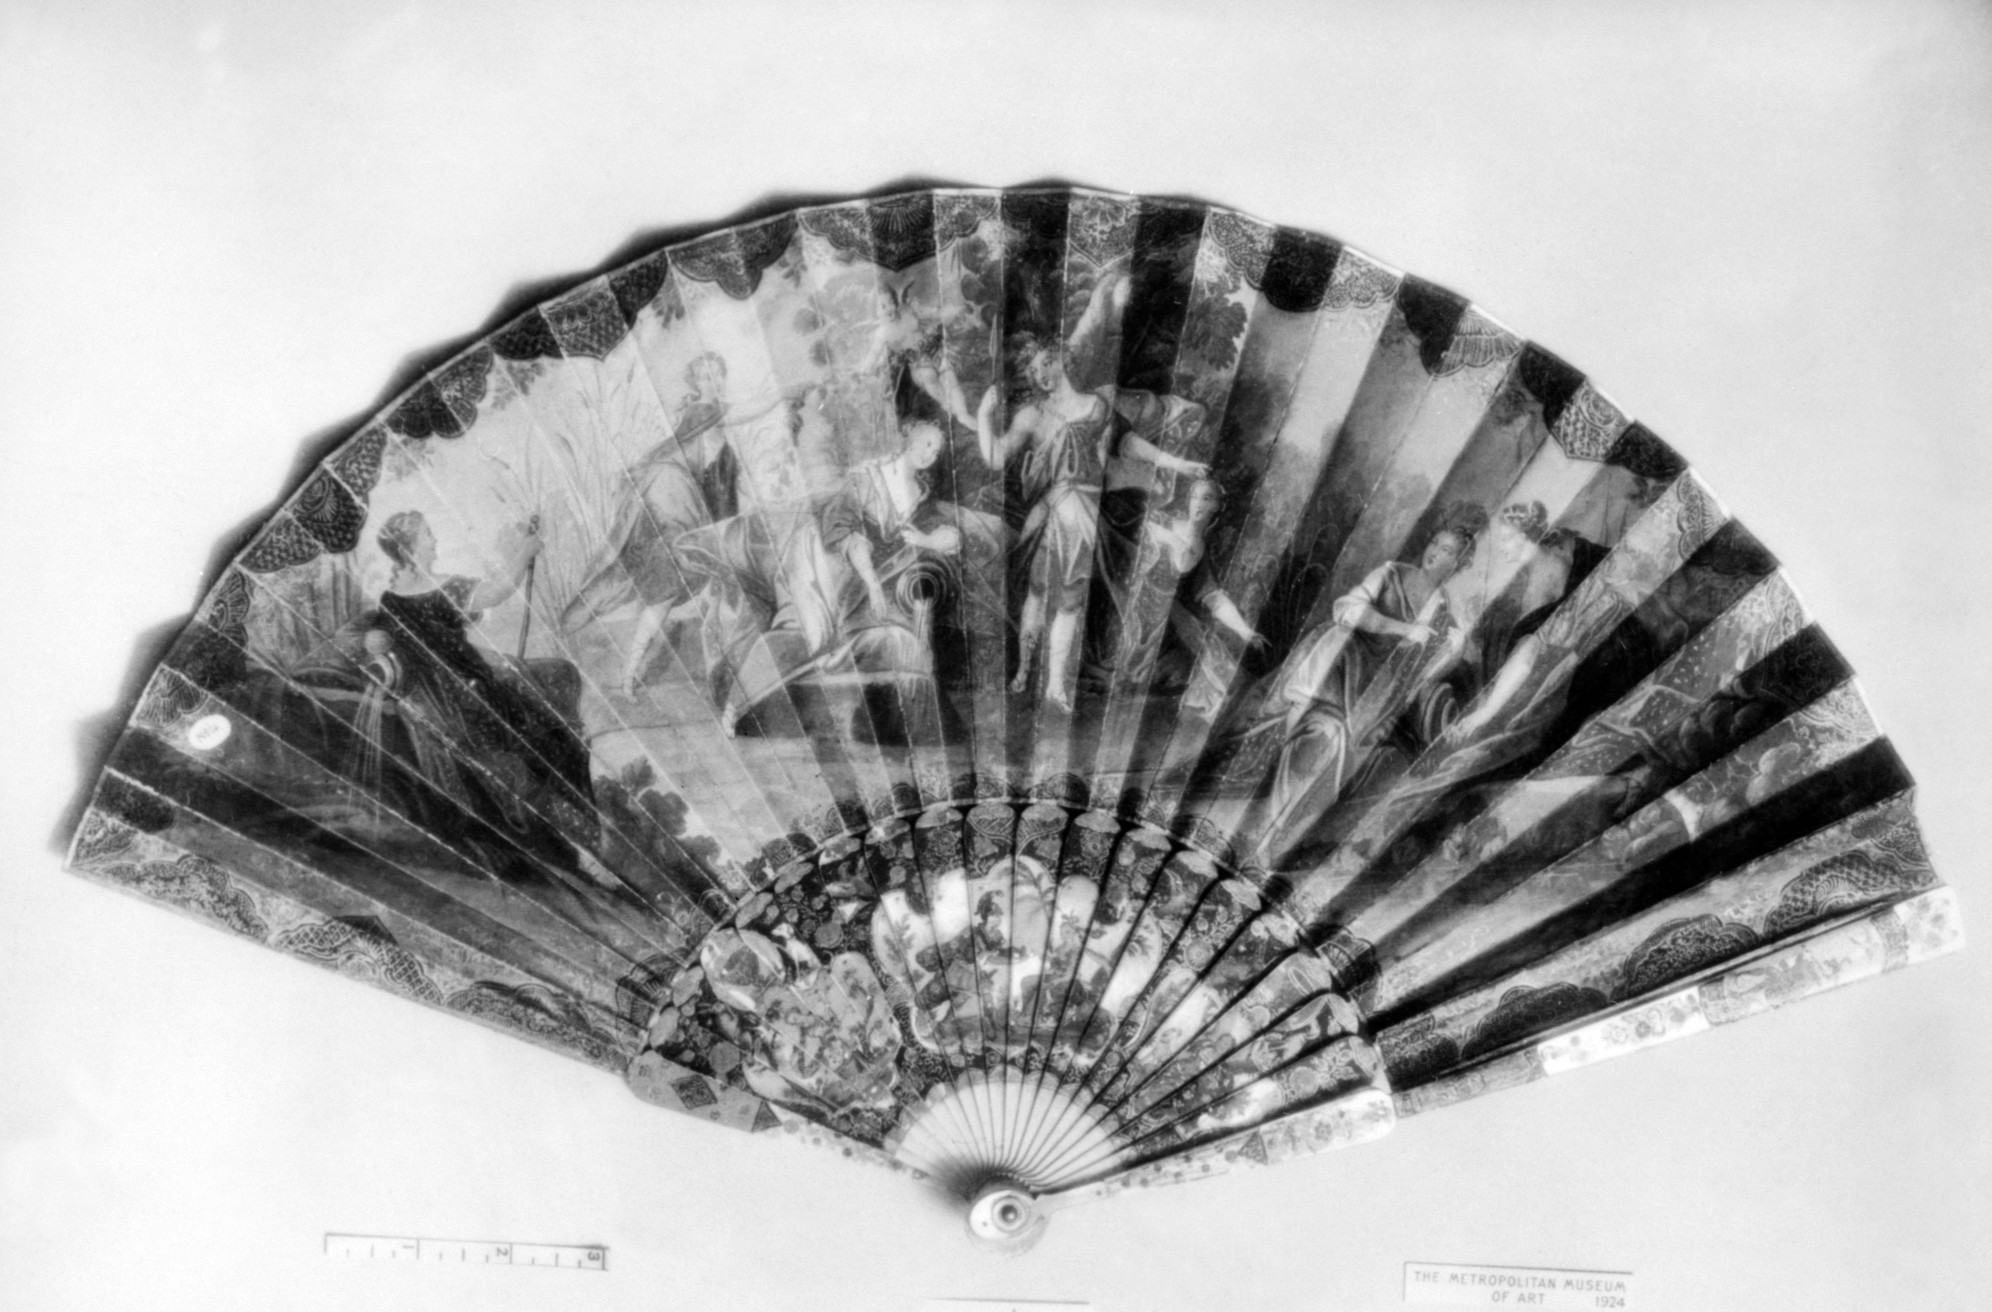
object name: fan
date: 1701-1733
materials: ivory, skin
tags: women